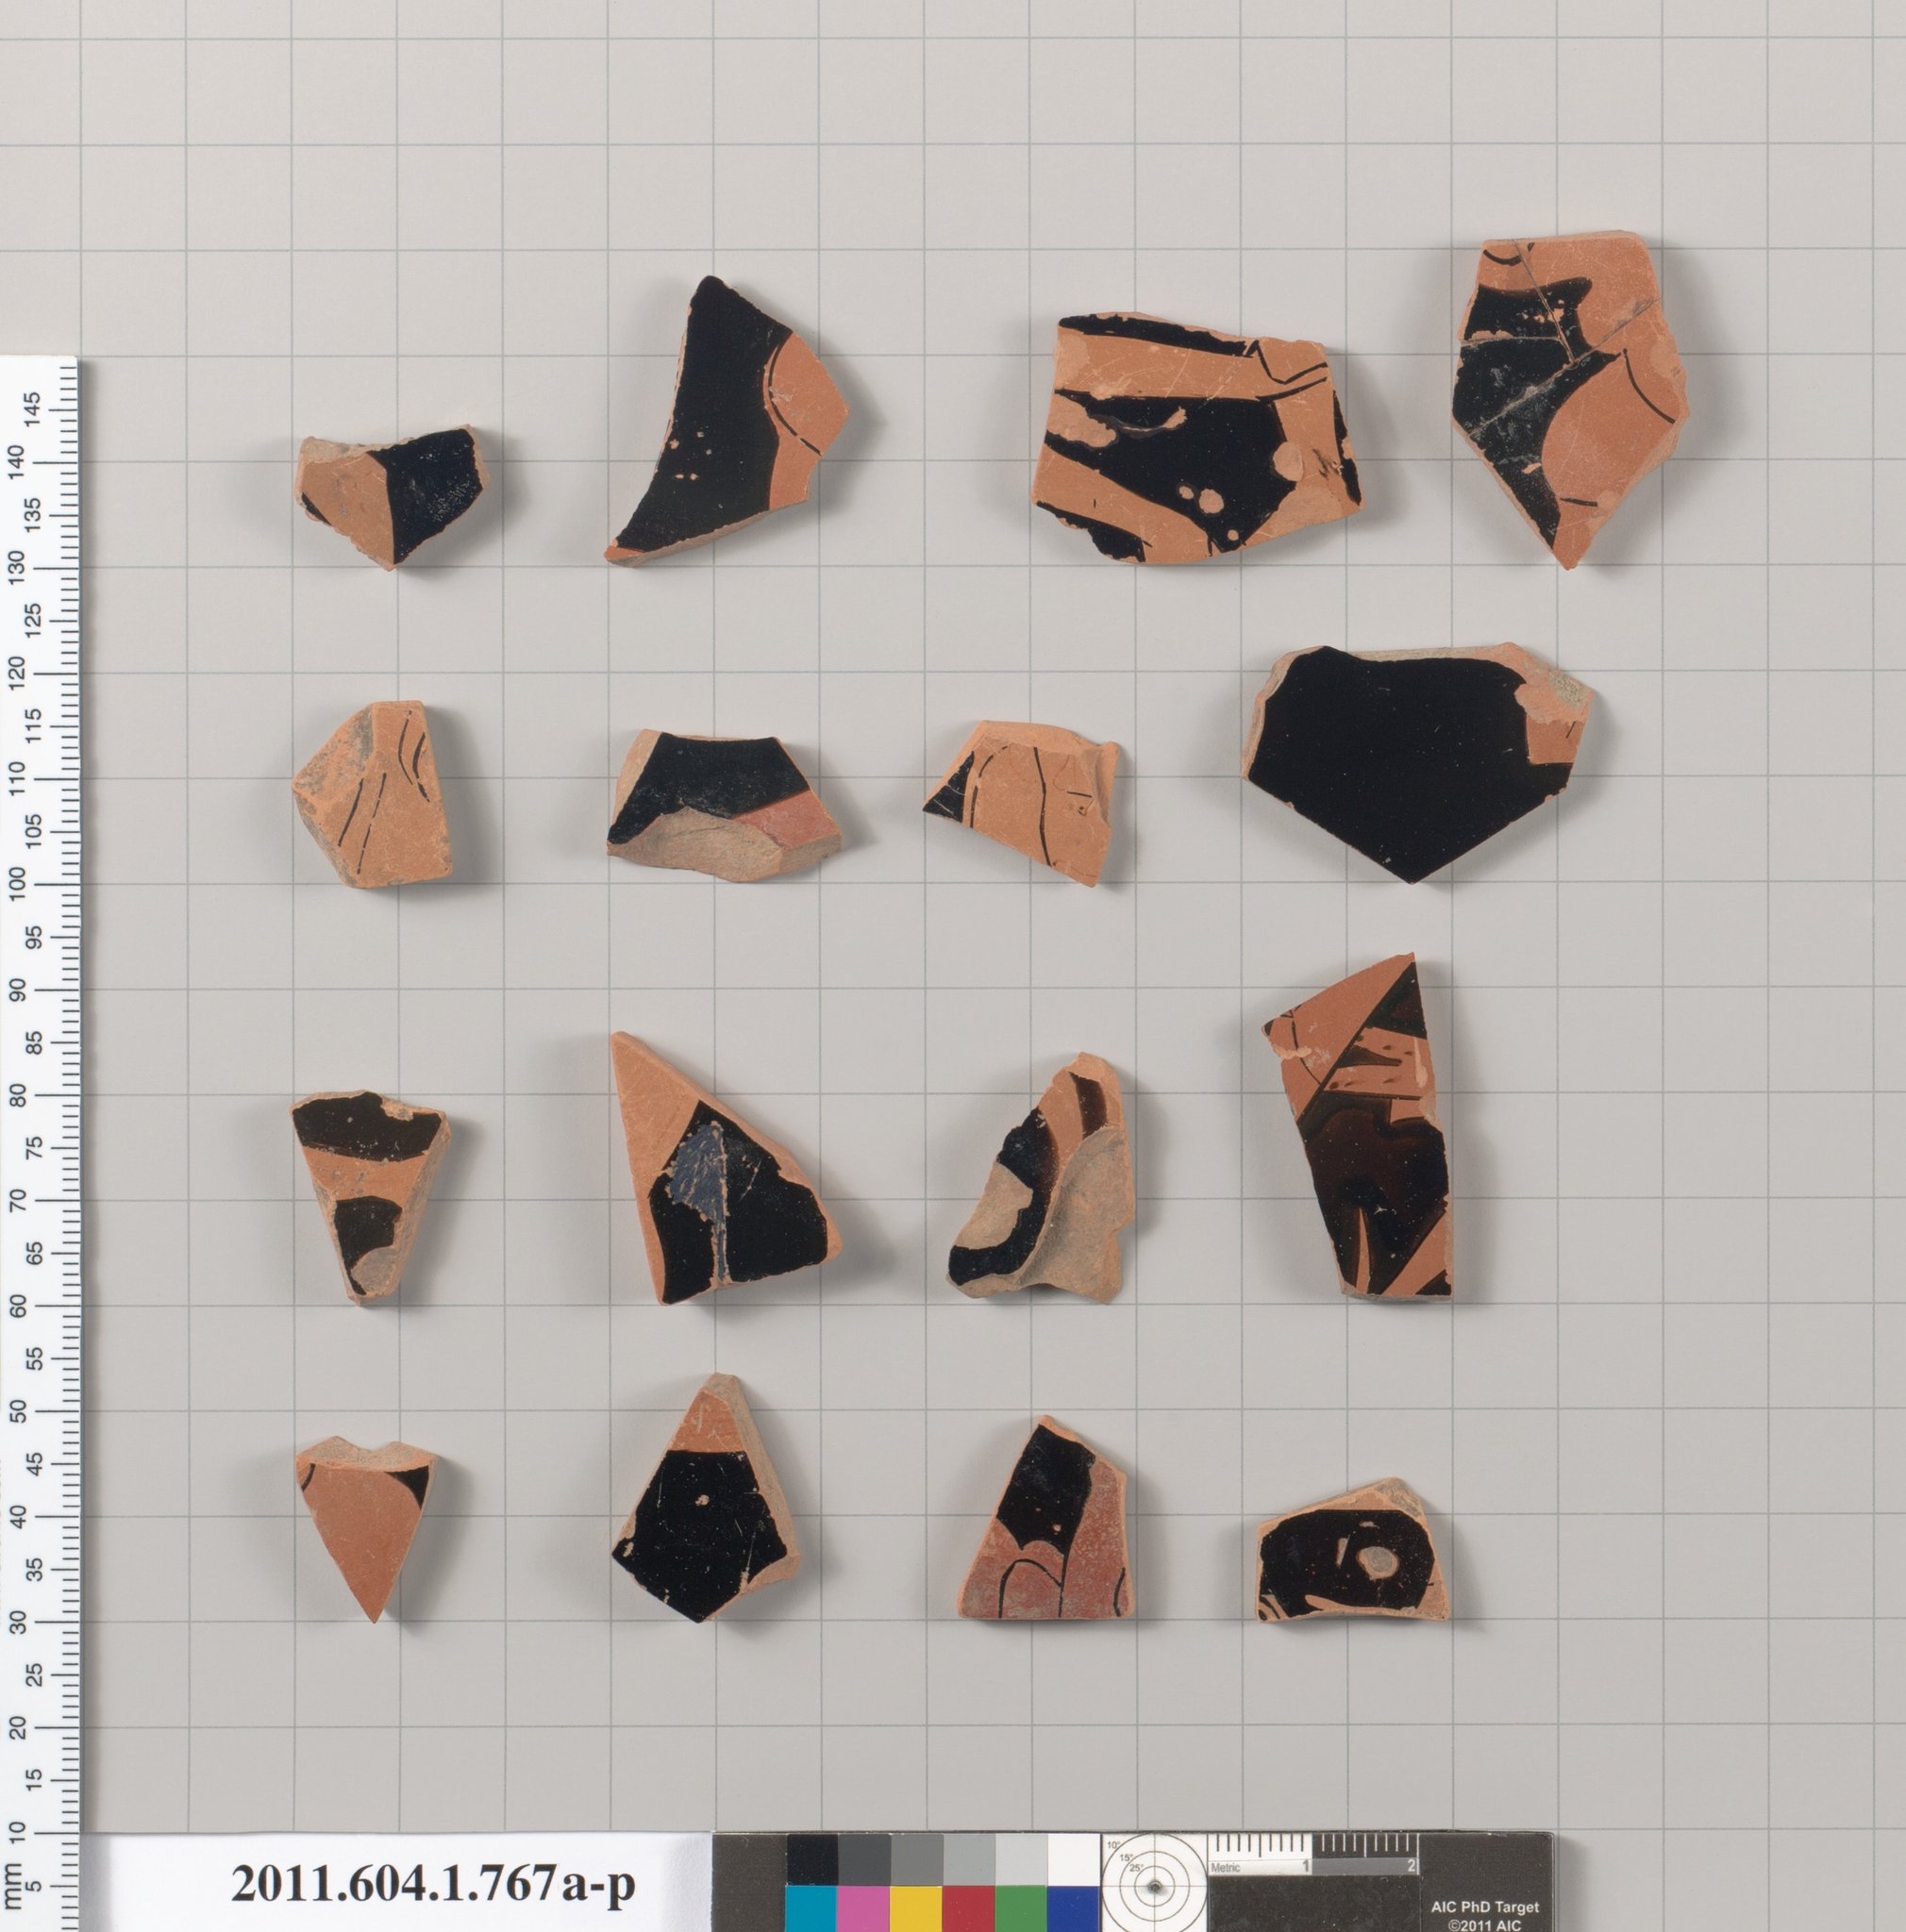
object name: kylix fragment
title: Terracotta fragments of kylikes (drinking cups)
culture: greek, attic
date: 500-401 BCE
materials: terracotta